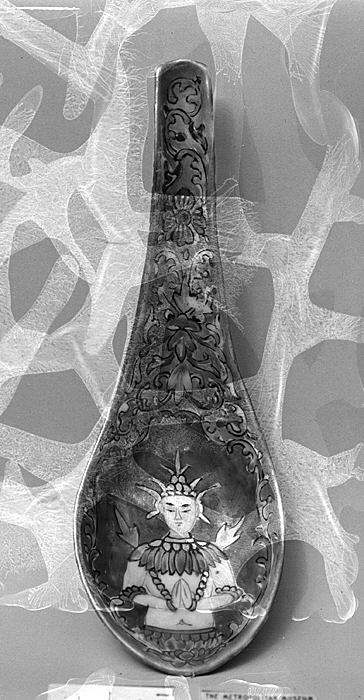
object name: spoon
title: Spoon with Thai mythical figure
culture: chinese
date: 1801-1900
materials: enamel, porcelain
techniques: overglaze, painting, polychrome